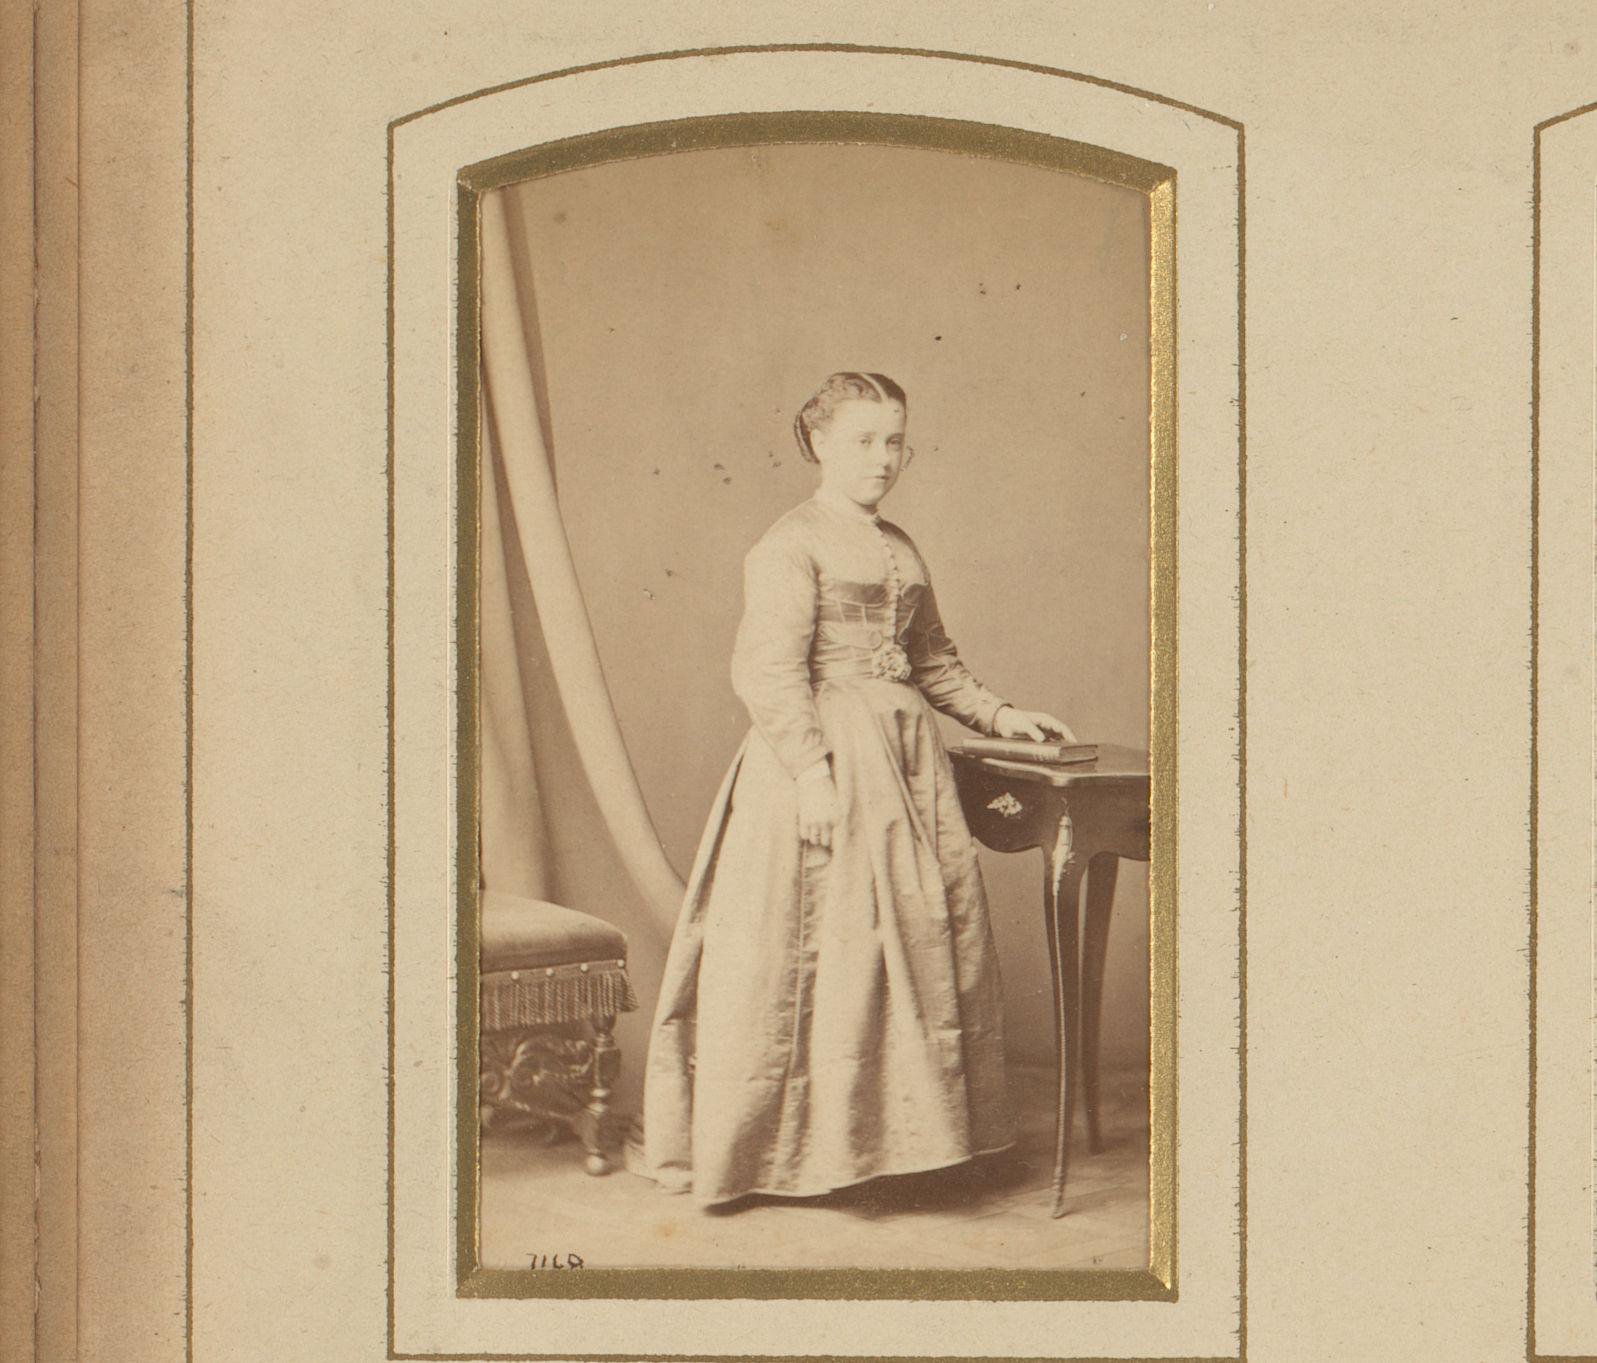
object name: album leaf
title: Portret van een jonge vrouw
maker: alfred hugh harman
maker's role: fotograaf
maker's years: 1841-1913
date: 1867-1879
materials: cardboard, photographic support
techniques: albumen print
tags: adolescent, young woman, maiden, historical persons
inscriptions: inscription: ‘Alfred Harman & Co./ Photographic Establishment/ 79, High Street Peckham/ (...)’